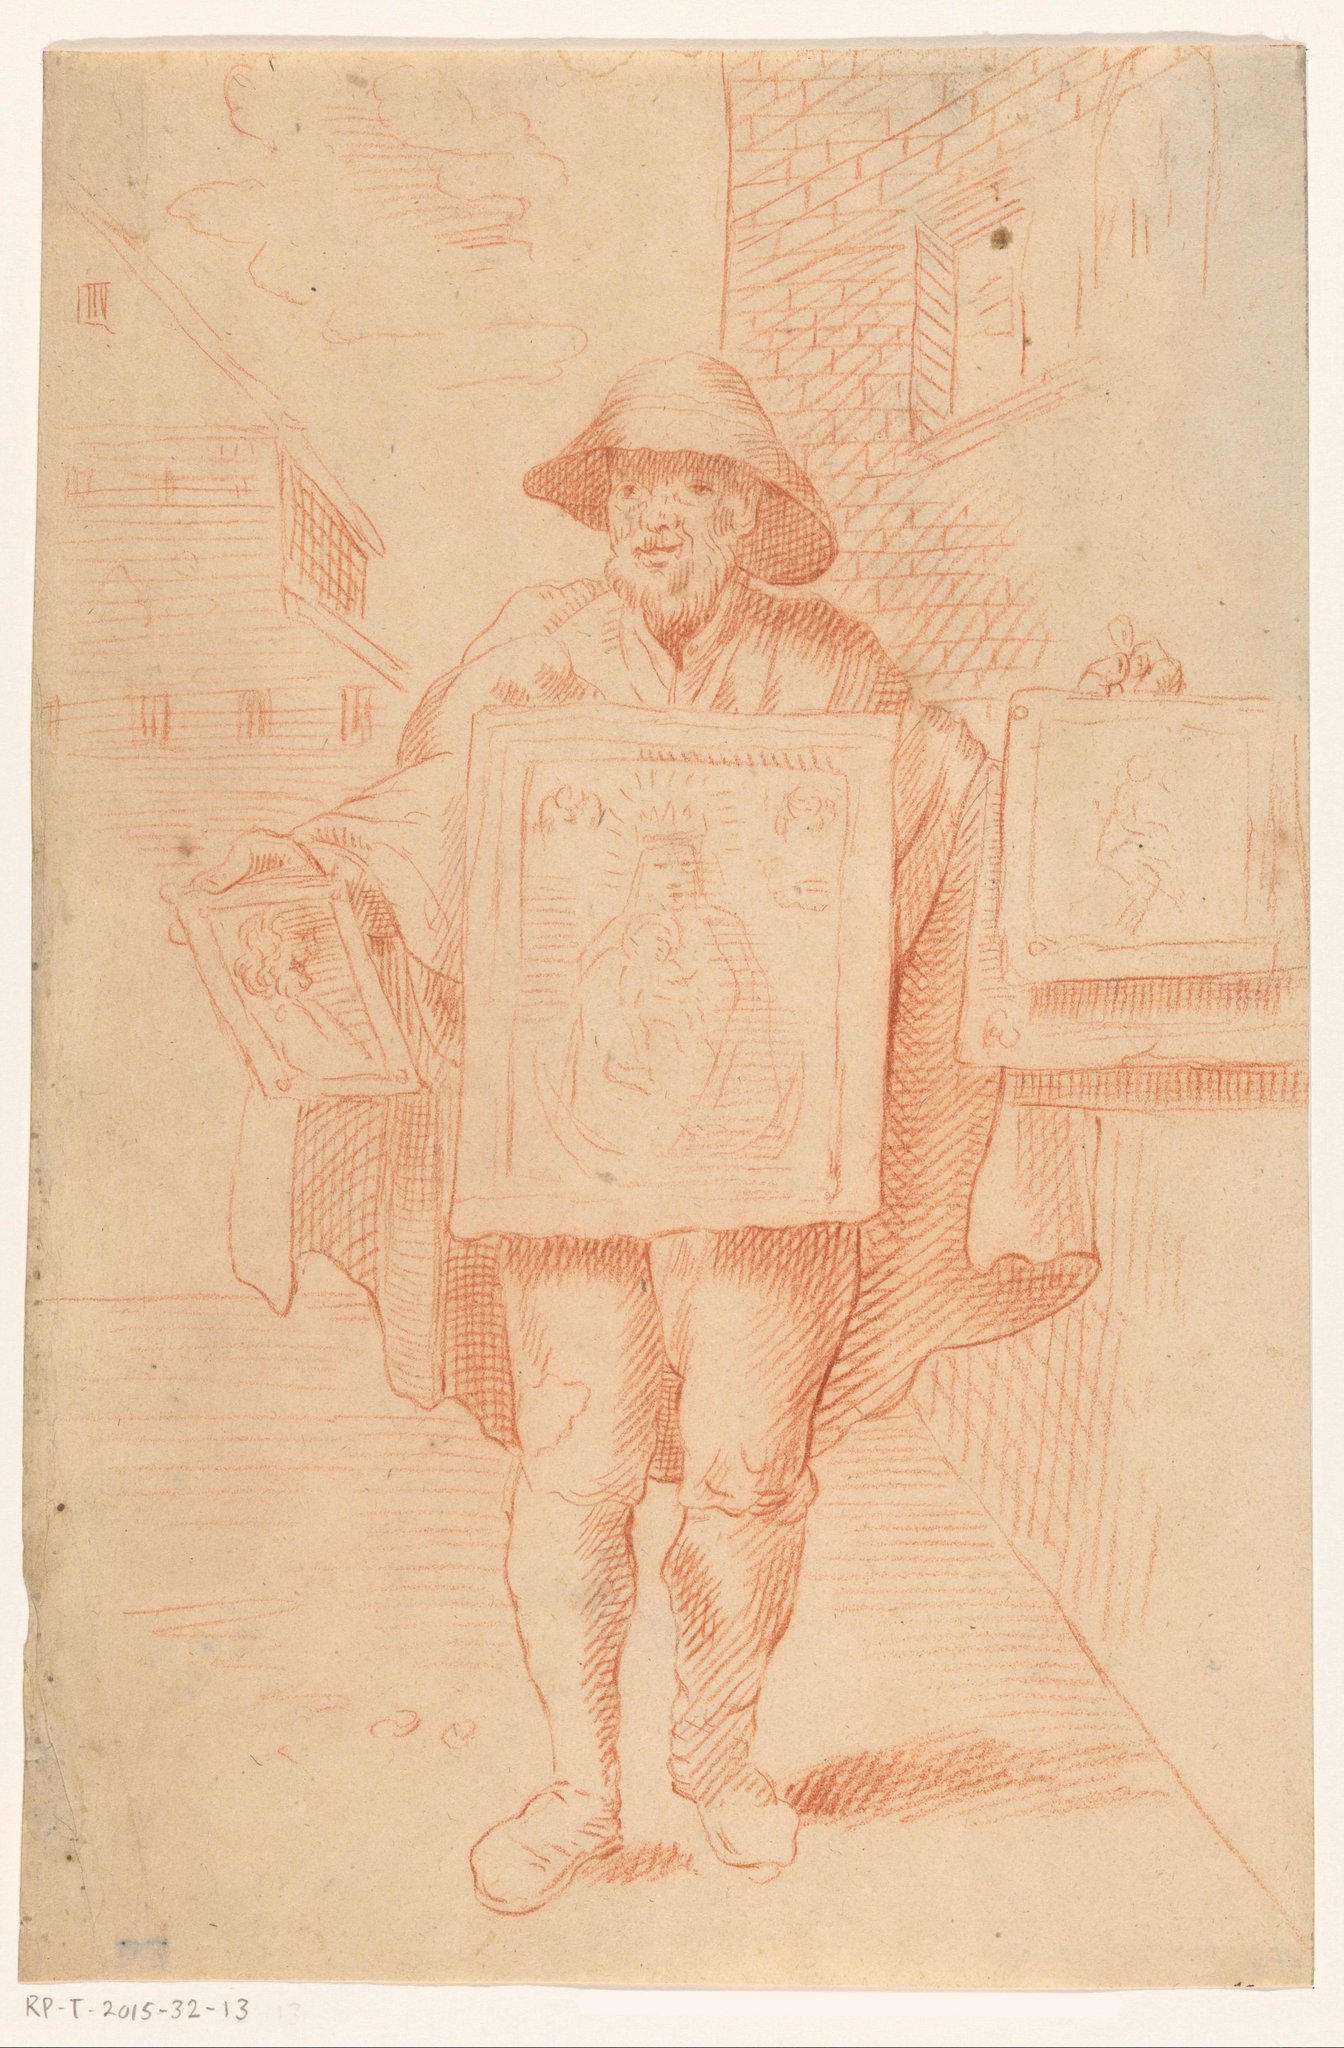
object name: drawing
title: Prentverkoper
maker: Anonymous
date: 1600-1699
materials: chalk, paper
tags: print, e.g.: engraving, etching, lithograph, street-trader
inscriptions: collector's mark: Lugt 4779, collector's mark: Lugt 2228, watermark: ‘posthoorn’, collector's mark: Lugt 4780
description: Gezicht op een plein met een prentverkoper met een mantel en een hoed. In beide handen houdt hij bundels prenten, om zijn nek een prent met als voorstelling Maria met kind.